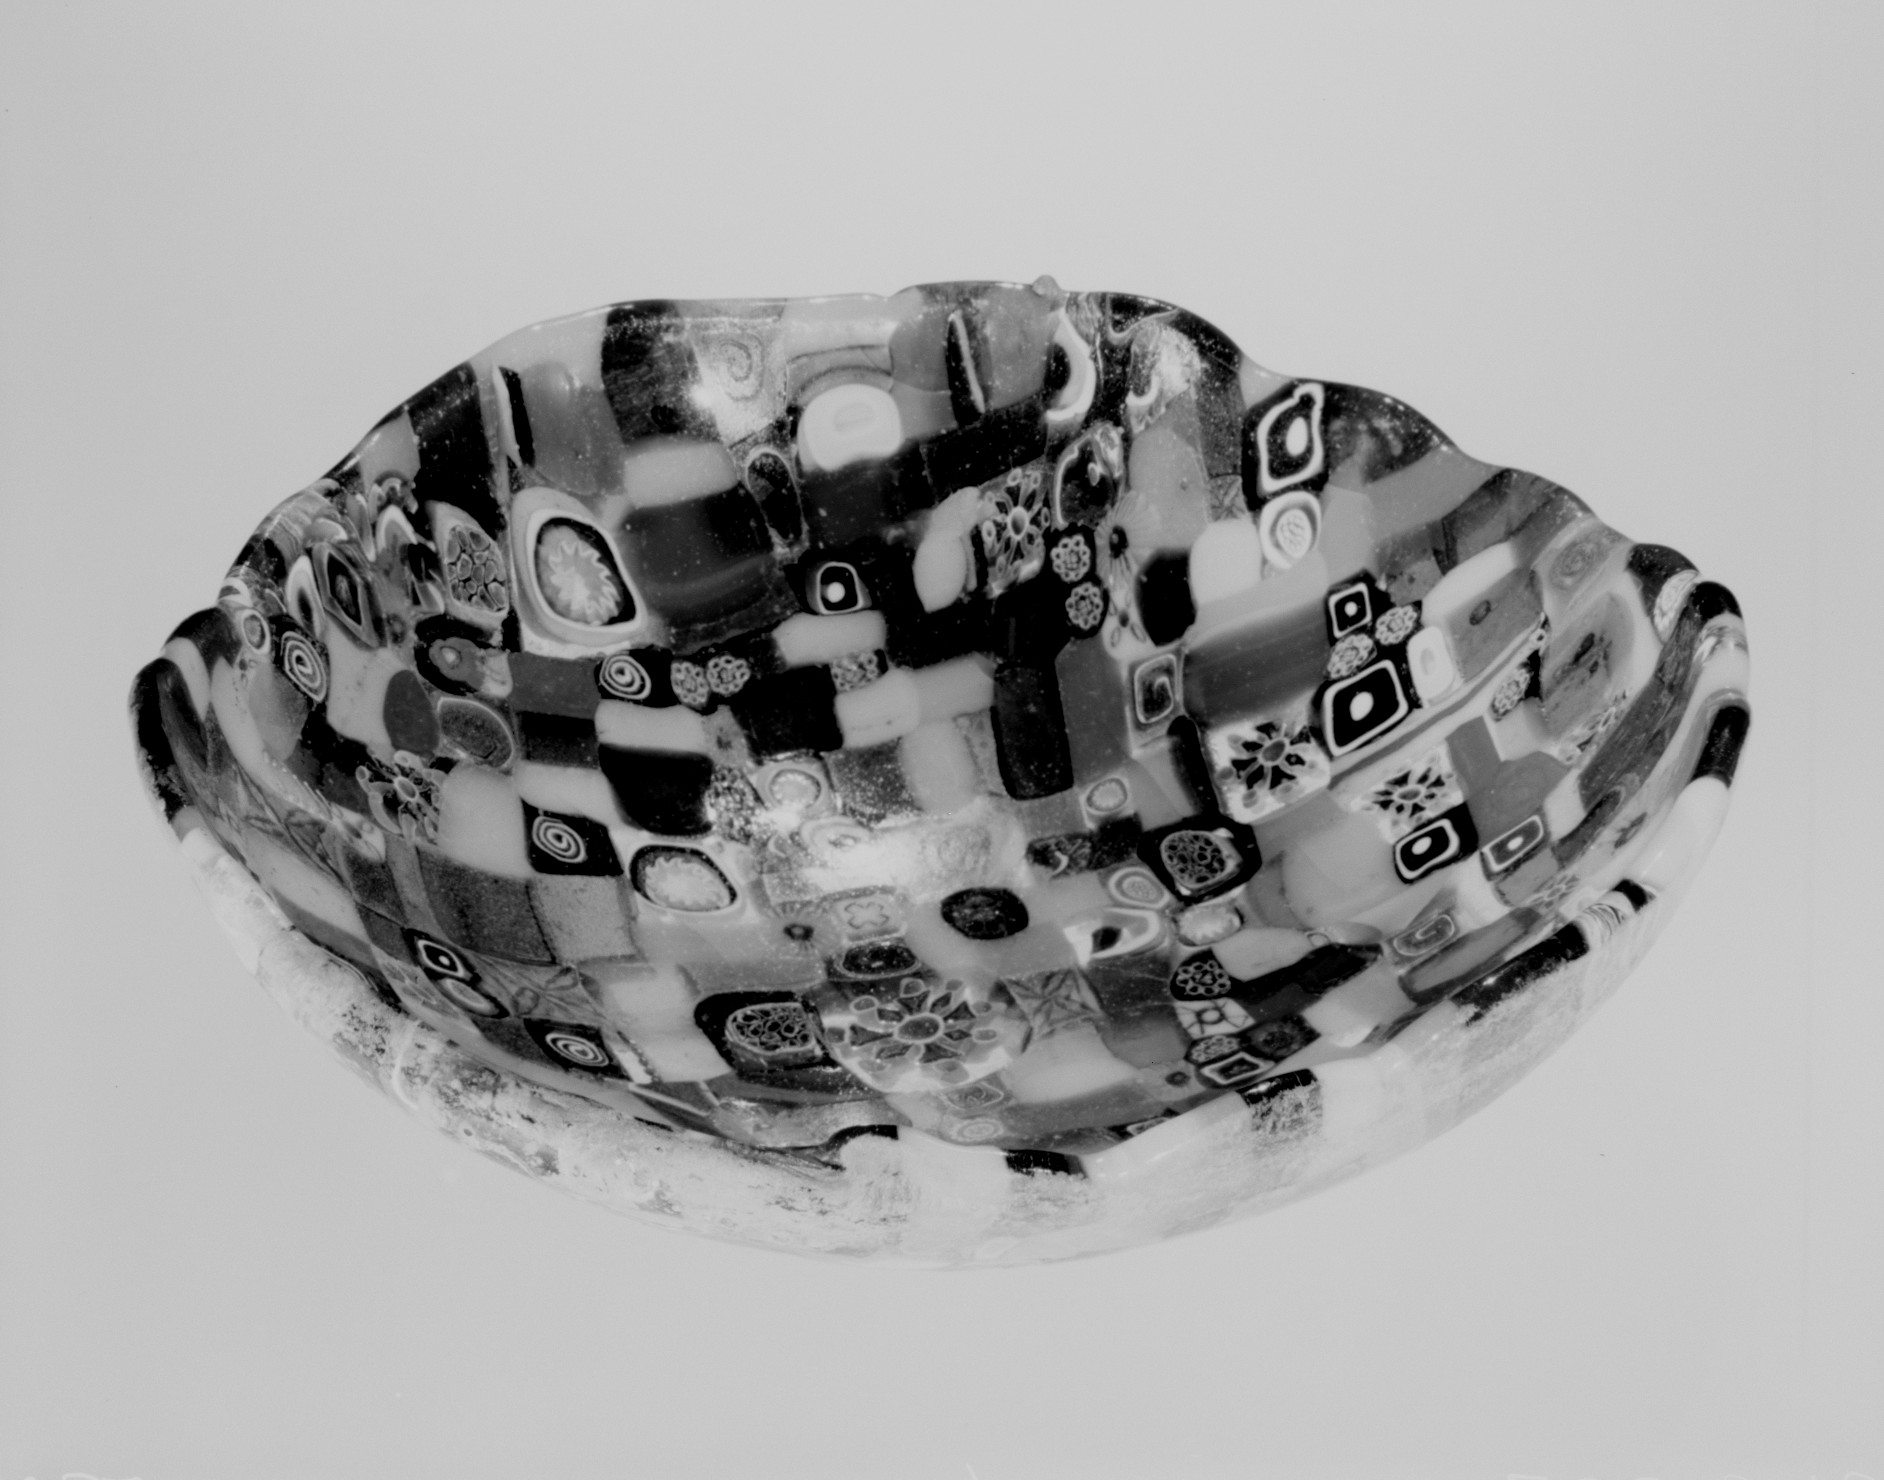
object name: bowl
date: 1880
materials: glass